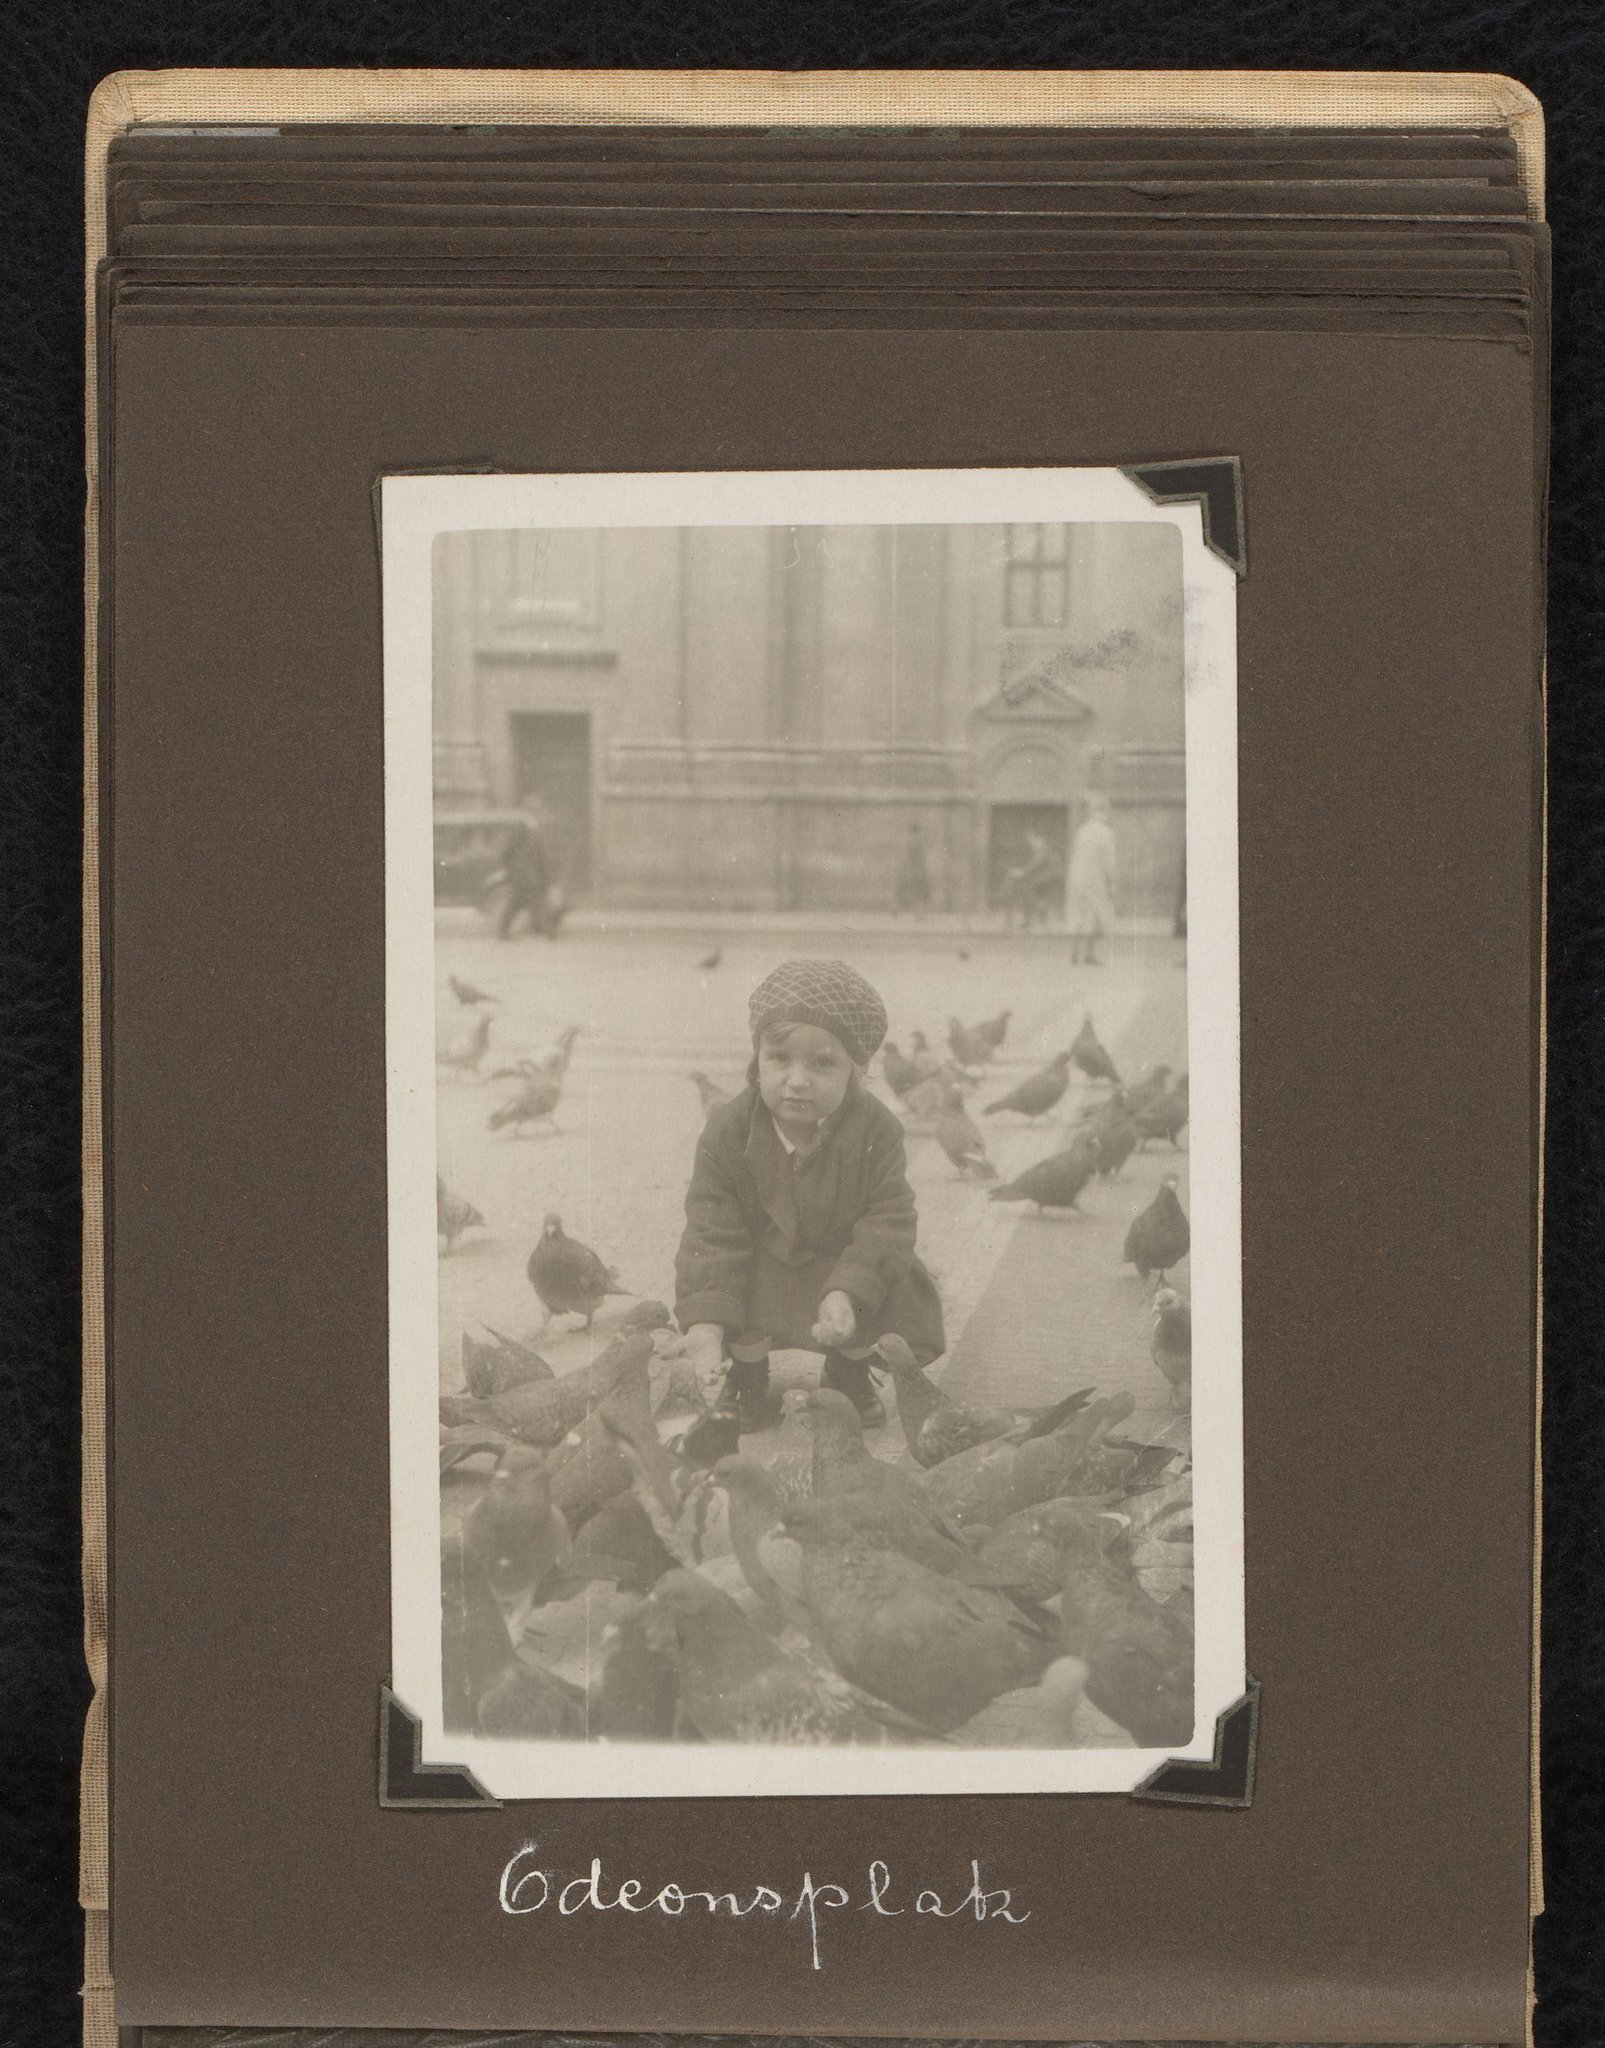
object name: album leaf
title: Isabel Wachenheimer voert duiven op de Odeonsplatz, juli 1931-februari 1932, München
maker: else wachenheimer-moos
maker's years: 1895-1944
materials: cardboard, photographic support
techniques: gelatin silver print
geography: munich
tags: leiden, isabel wachenheimer-elon, family life at home, feeding wild animals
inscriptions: inscription: ‘Odeonsplatz’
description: Blad bevat een foto. Alle foto's van Isabel Wachenheimer (als jong meisje). Uit het album, half formaat, crèmekleurig stofomslag met koordbinding met banenmotief.